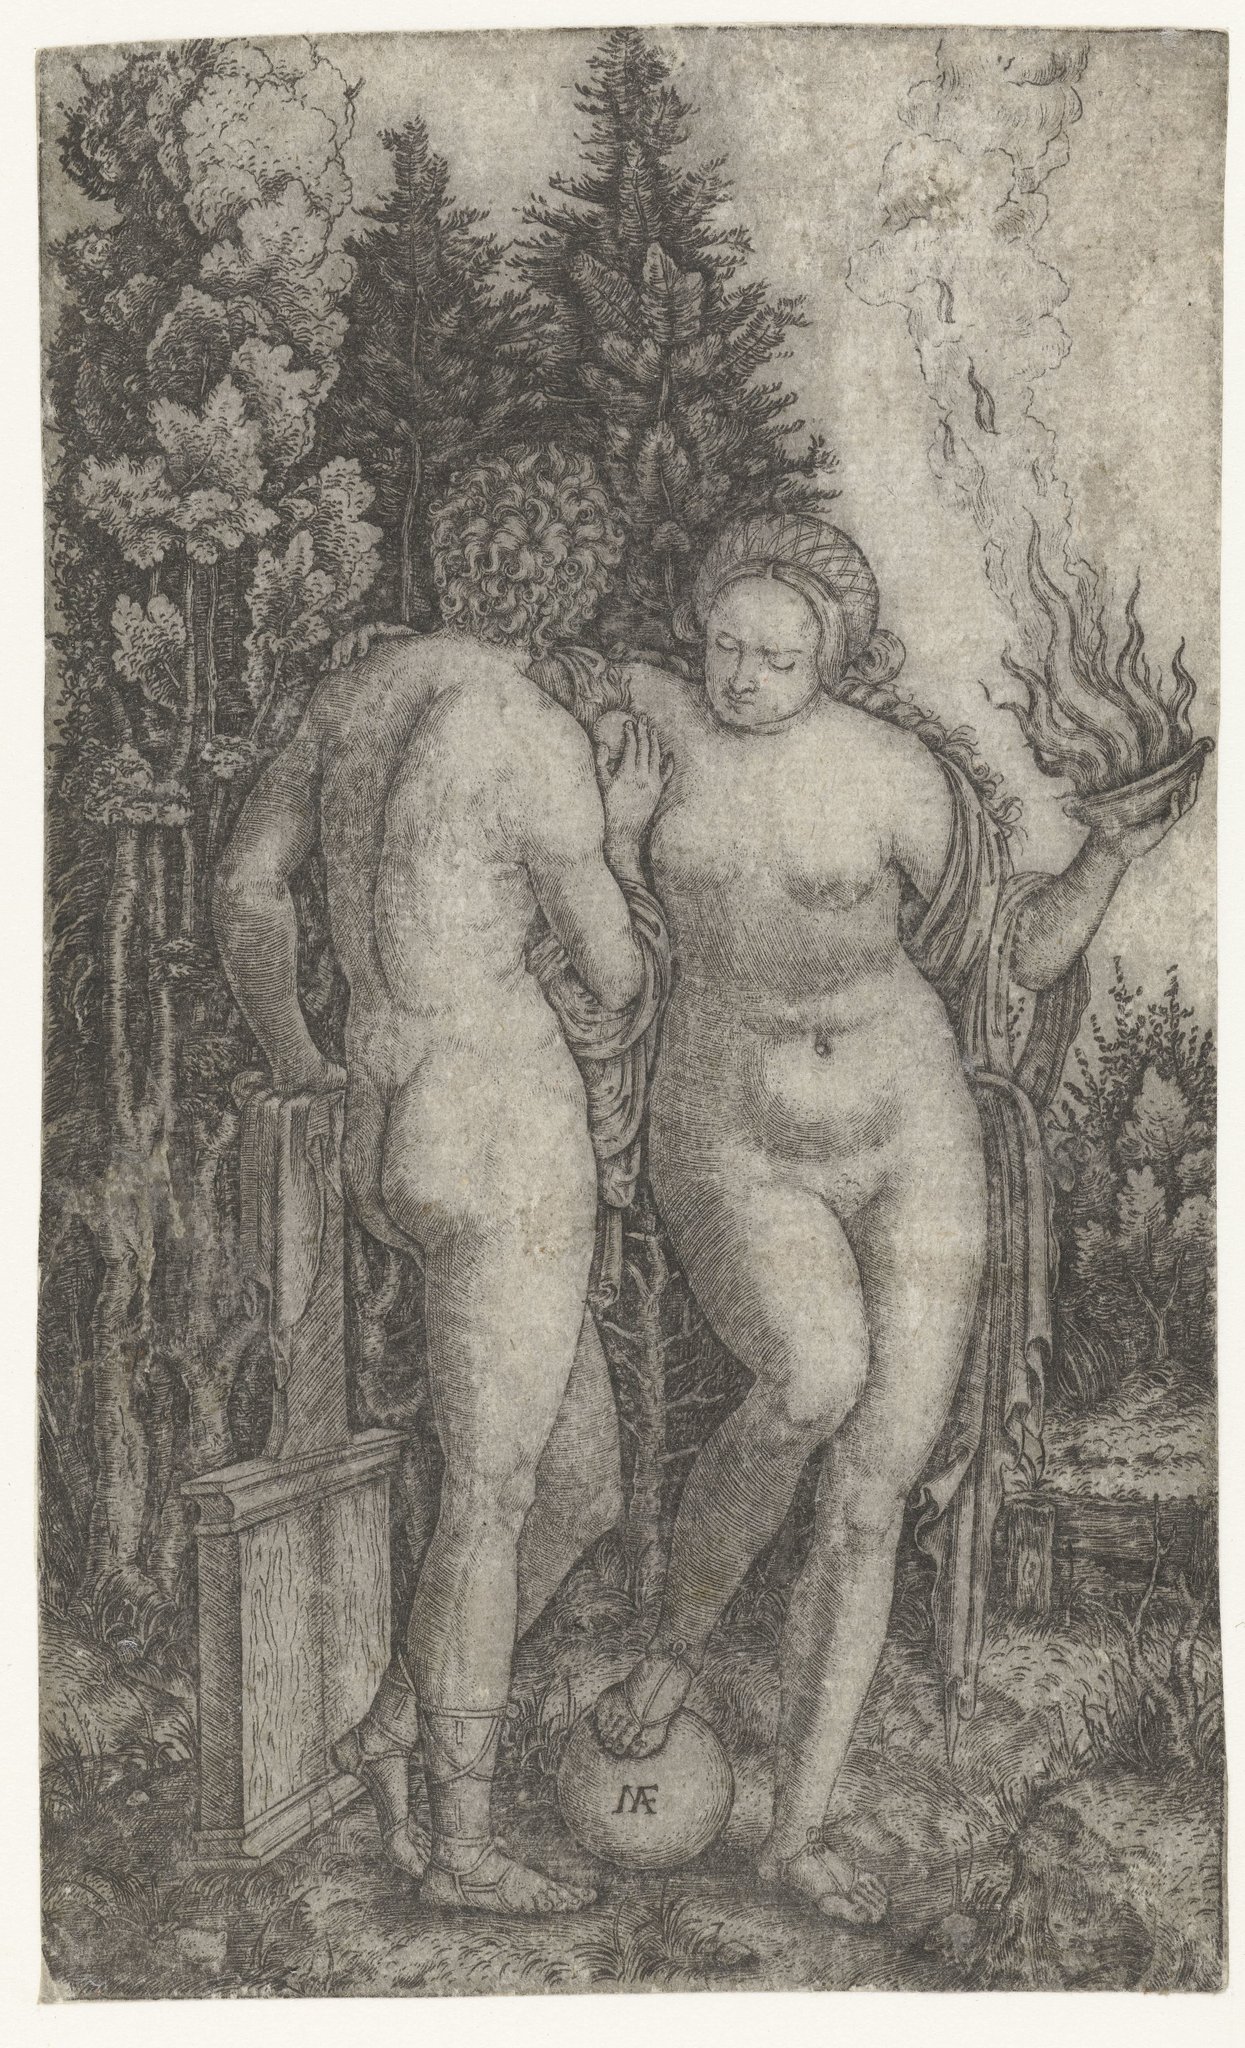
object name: print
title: Jongeman beschermd door vrouw met globe en offerschaal als personificatie van Fortuin (Fortuna)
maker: marcantonio raimondi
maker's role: print maker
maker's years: 1470-1534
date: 1506-1507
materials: paper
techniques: engraving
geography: italy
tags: luck, fortune, lot; 'fato', 'fortuna', 'fortuna aurea', 'fortuna buona', 'fortuna pacifica overo clemente', 'sorte' (ripa)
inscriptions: collector's mark: Lugt 12